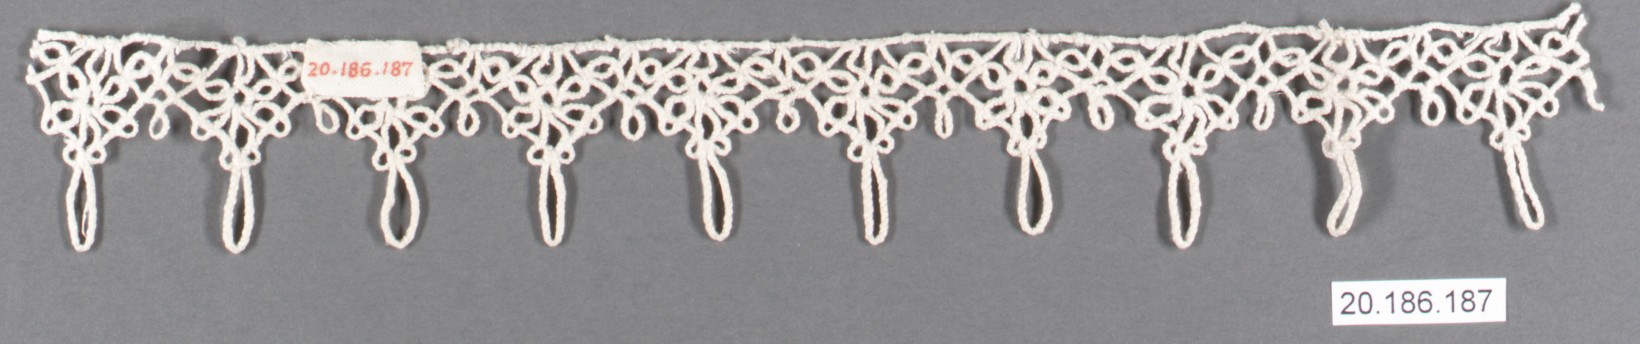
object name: edging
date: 1567-1633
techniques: lace